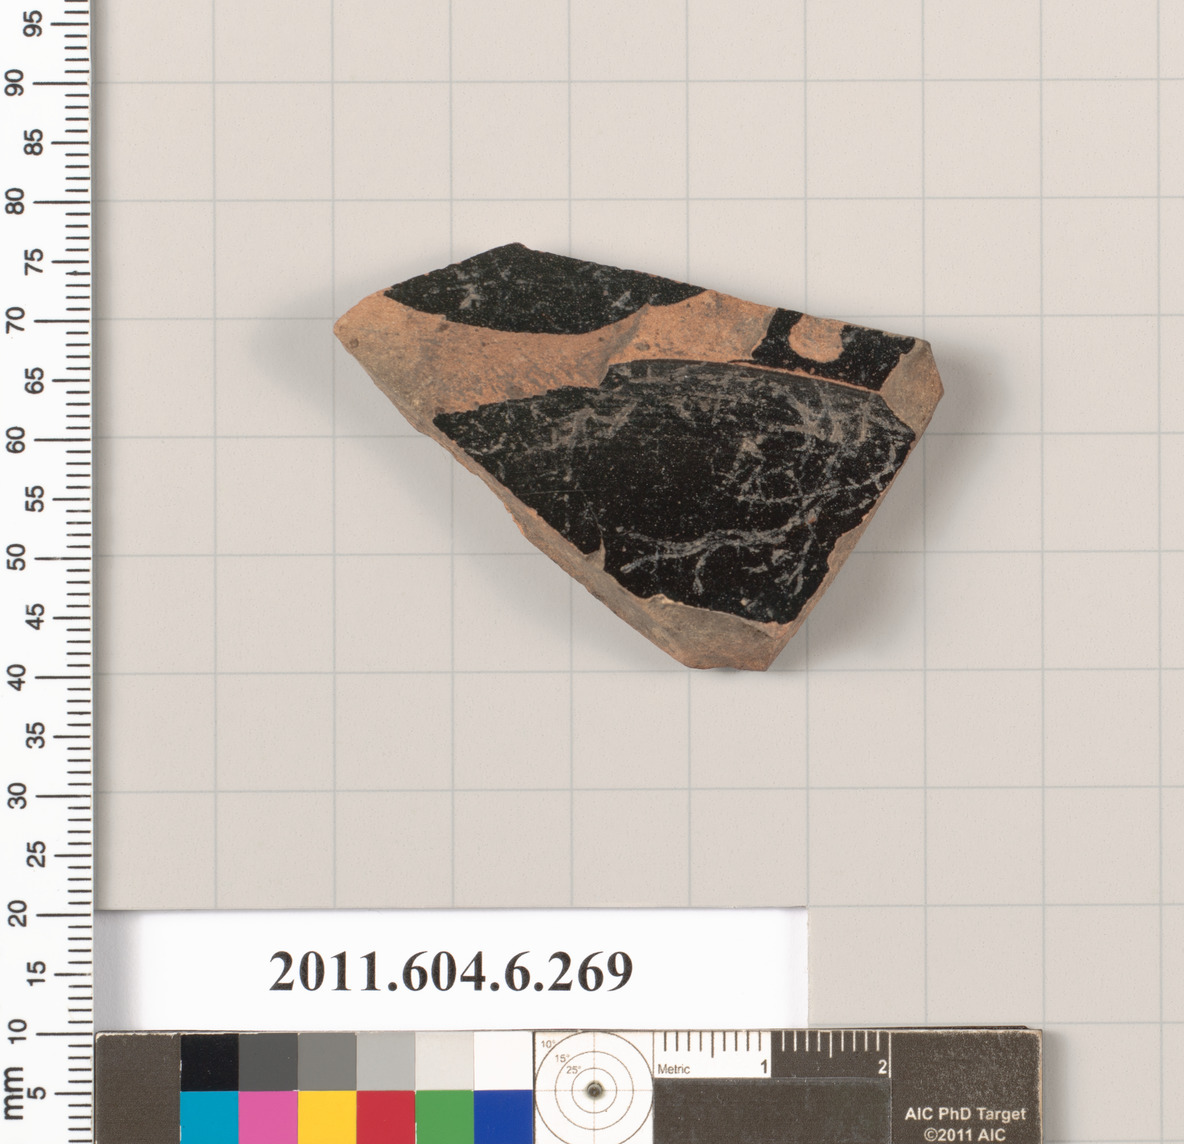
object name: plate fragment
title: Terracotta fragment of a plate?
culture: greek, attic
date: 500-401 BCE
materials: terracotta